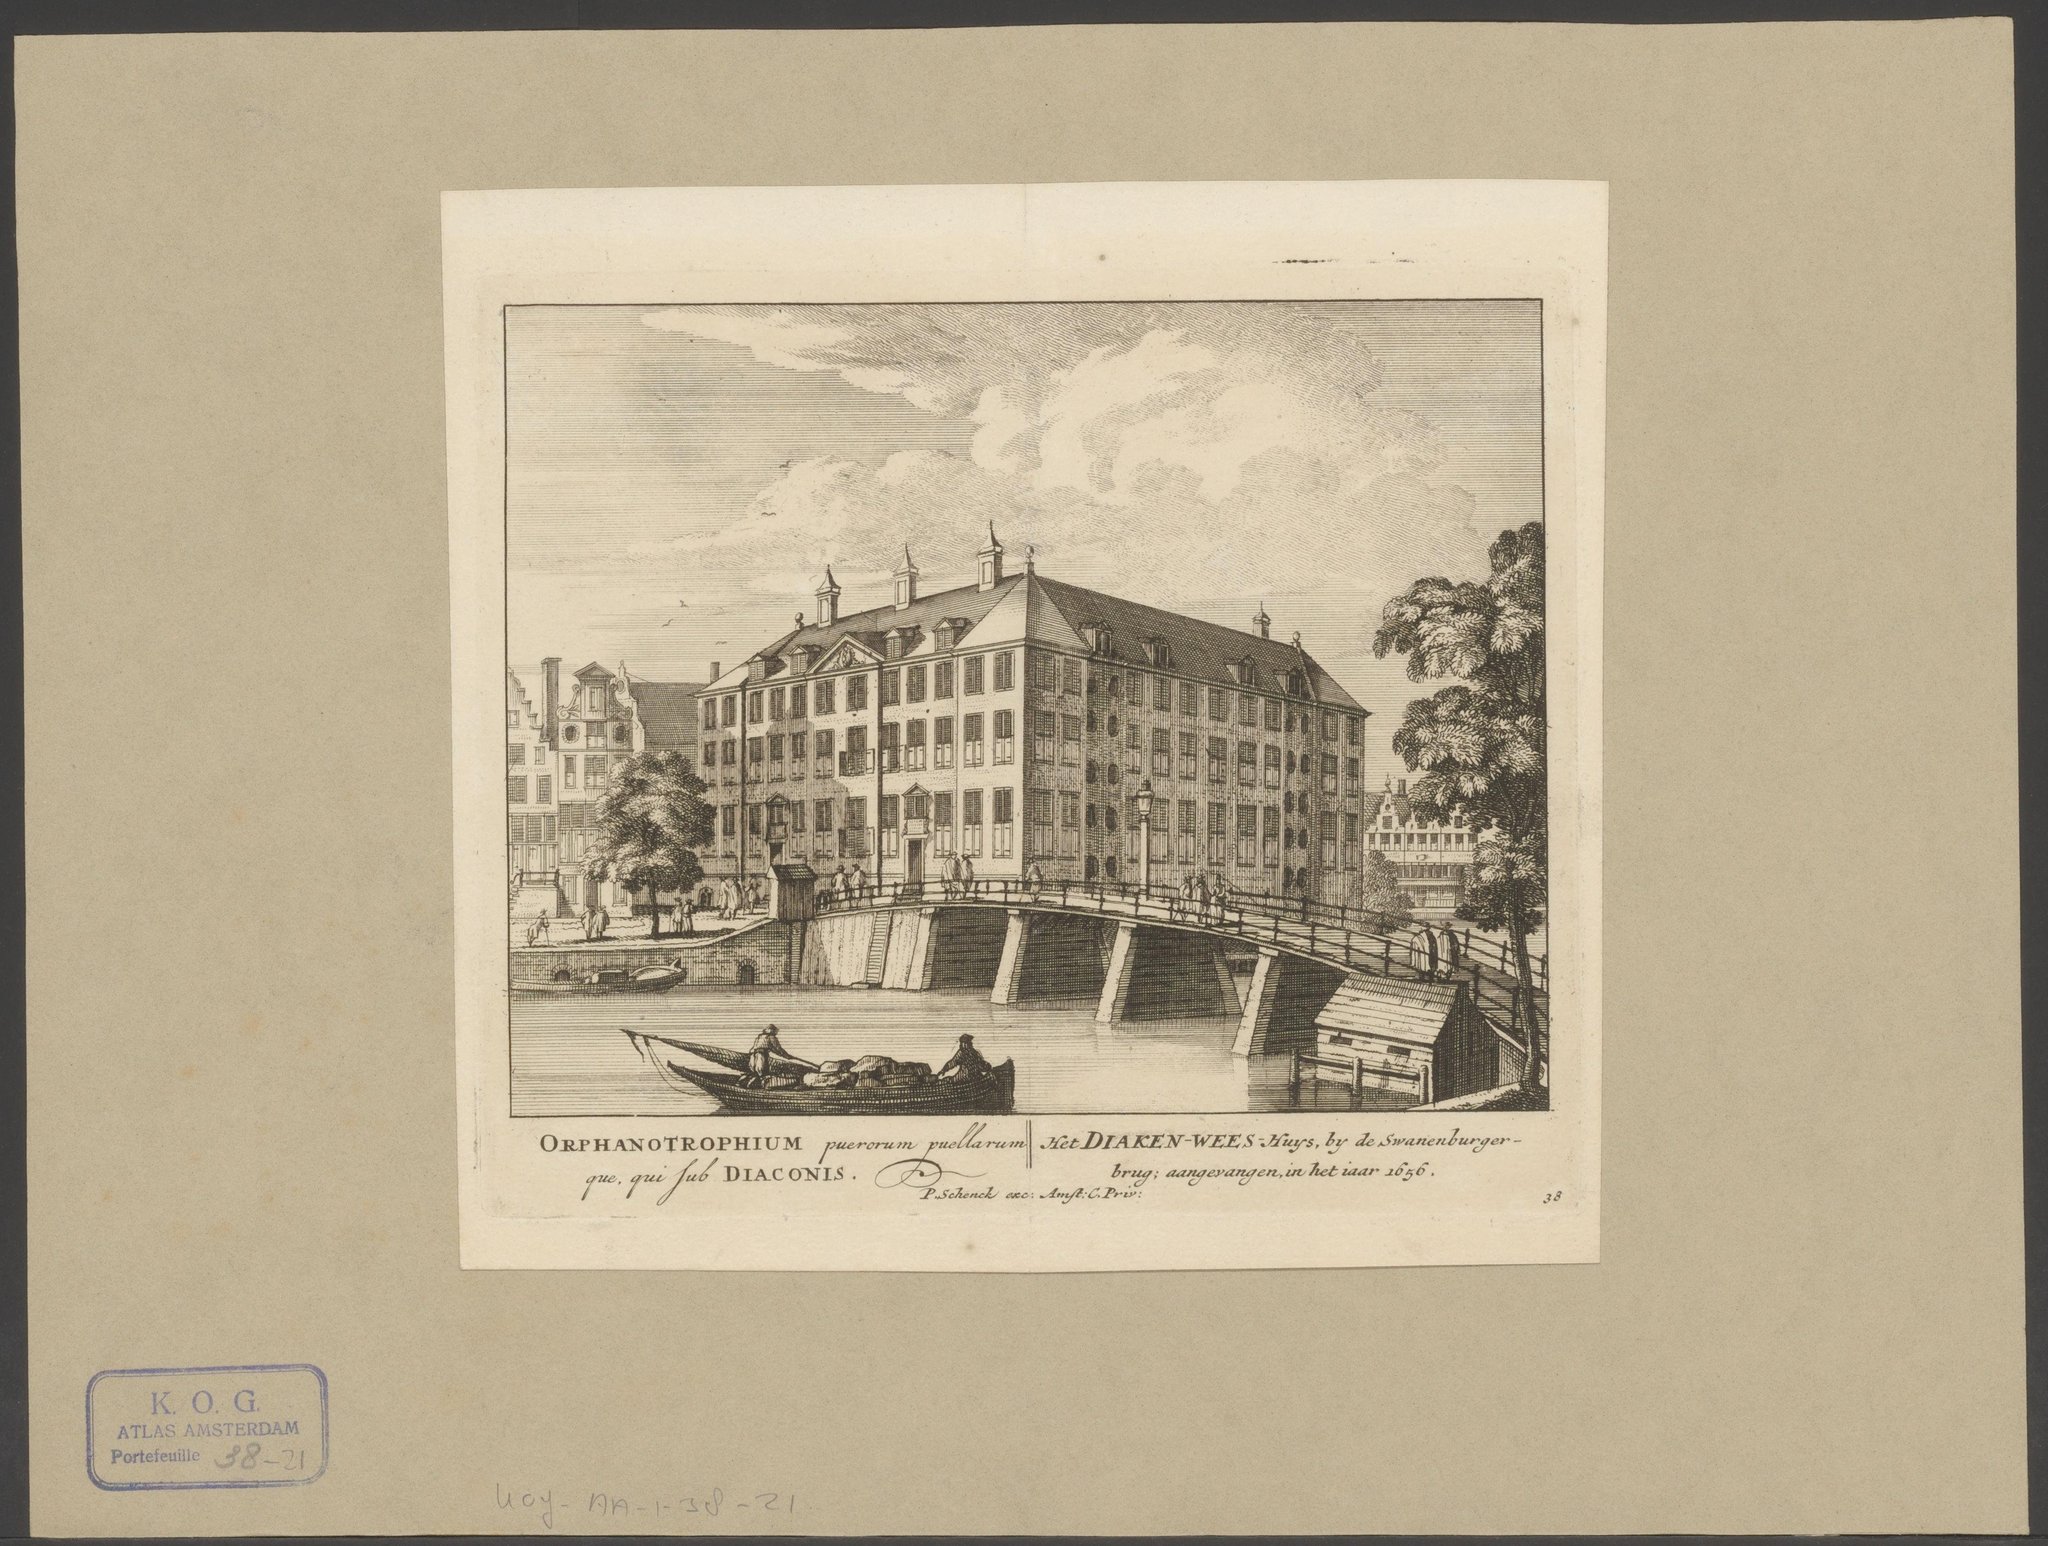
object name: print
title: Orphanotrophium puerorum puellarum que, qui sub Diaconis / Het Diaken-Wees-Huys, by de Swanenburger-brug; aangevangen, in het iaar 1656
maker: Anonymous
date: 1710-1711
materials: paper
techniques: engraving, etching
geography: northern netherlands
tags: bridge in city across river, canal, etc. (+ city(-scape) with figures, staffage), rowing-boat, canoe, etc., orphanage, canals, waters (in city) (+ city(-scape) with figures, staffage)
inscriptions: collector's mark: Lugt 1641b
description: Prent mogelijk uit: 100 Afbeeldinge der voornaamste gebouwen van Amsterdam. Amsterdam: Pieter Schenk (I), s.a. [1710-1711]. Of uit: 100 Afbeeldinge der voornaamste gebouwen van Amsterdam. Amsterdam: Barent Greve, s.a. [1757-1766]. In de tweede uitgave, uitgegeven door Barent Greve, is alleen de titelprent aangepast. De overige prenten zijn onveranderd gebleven.